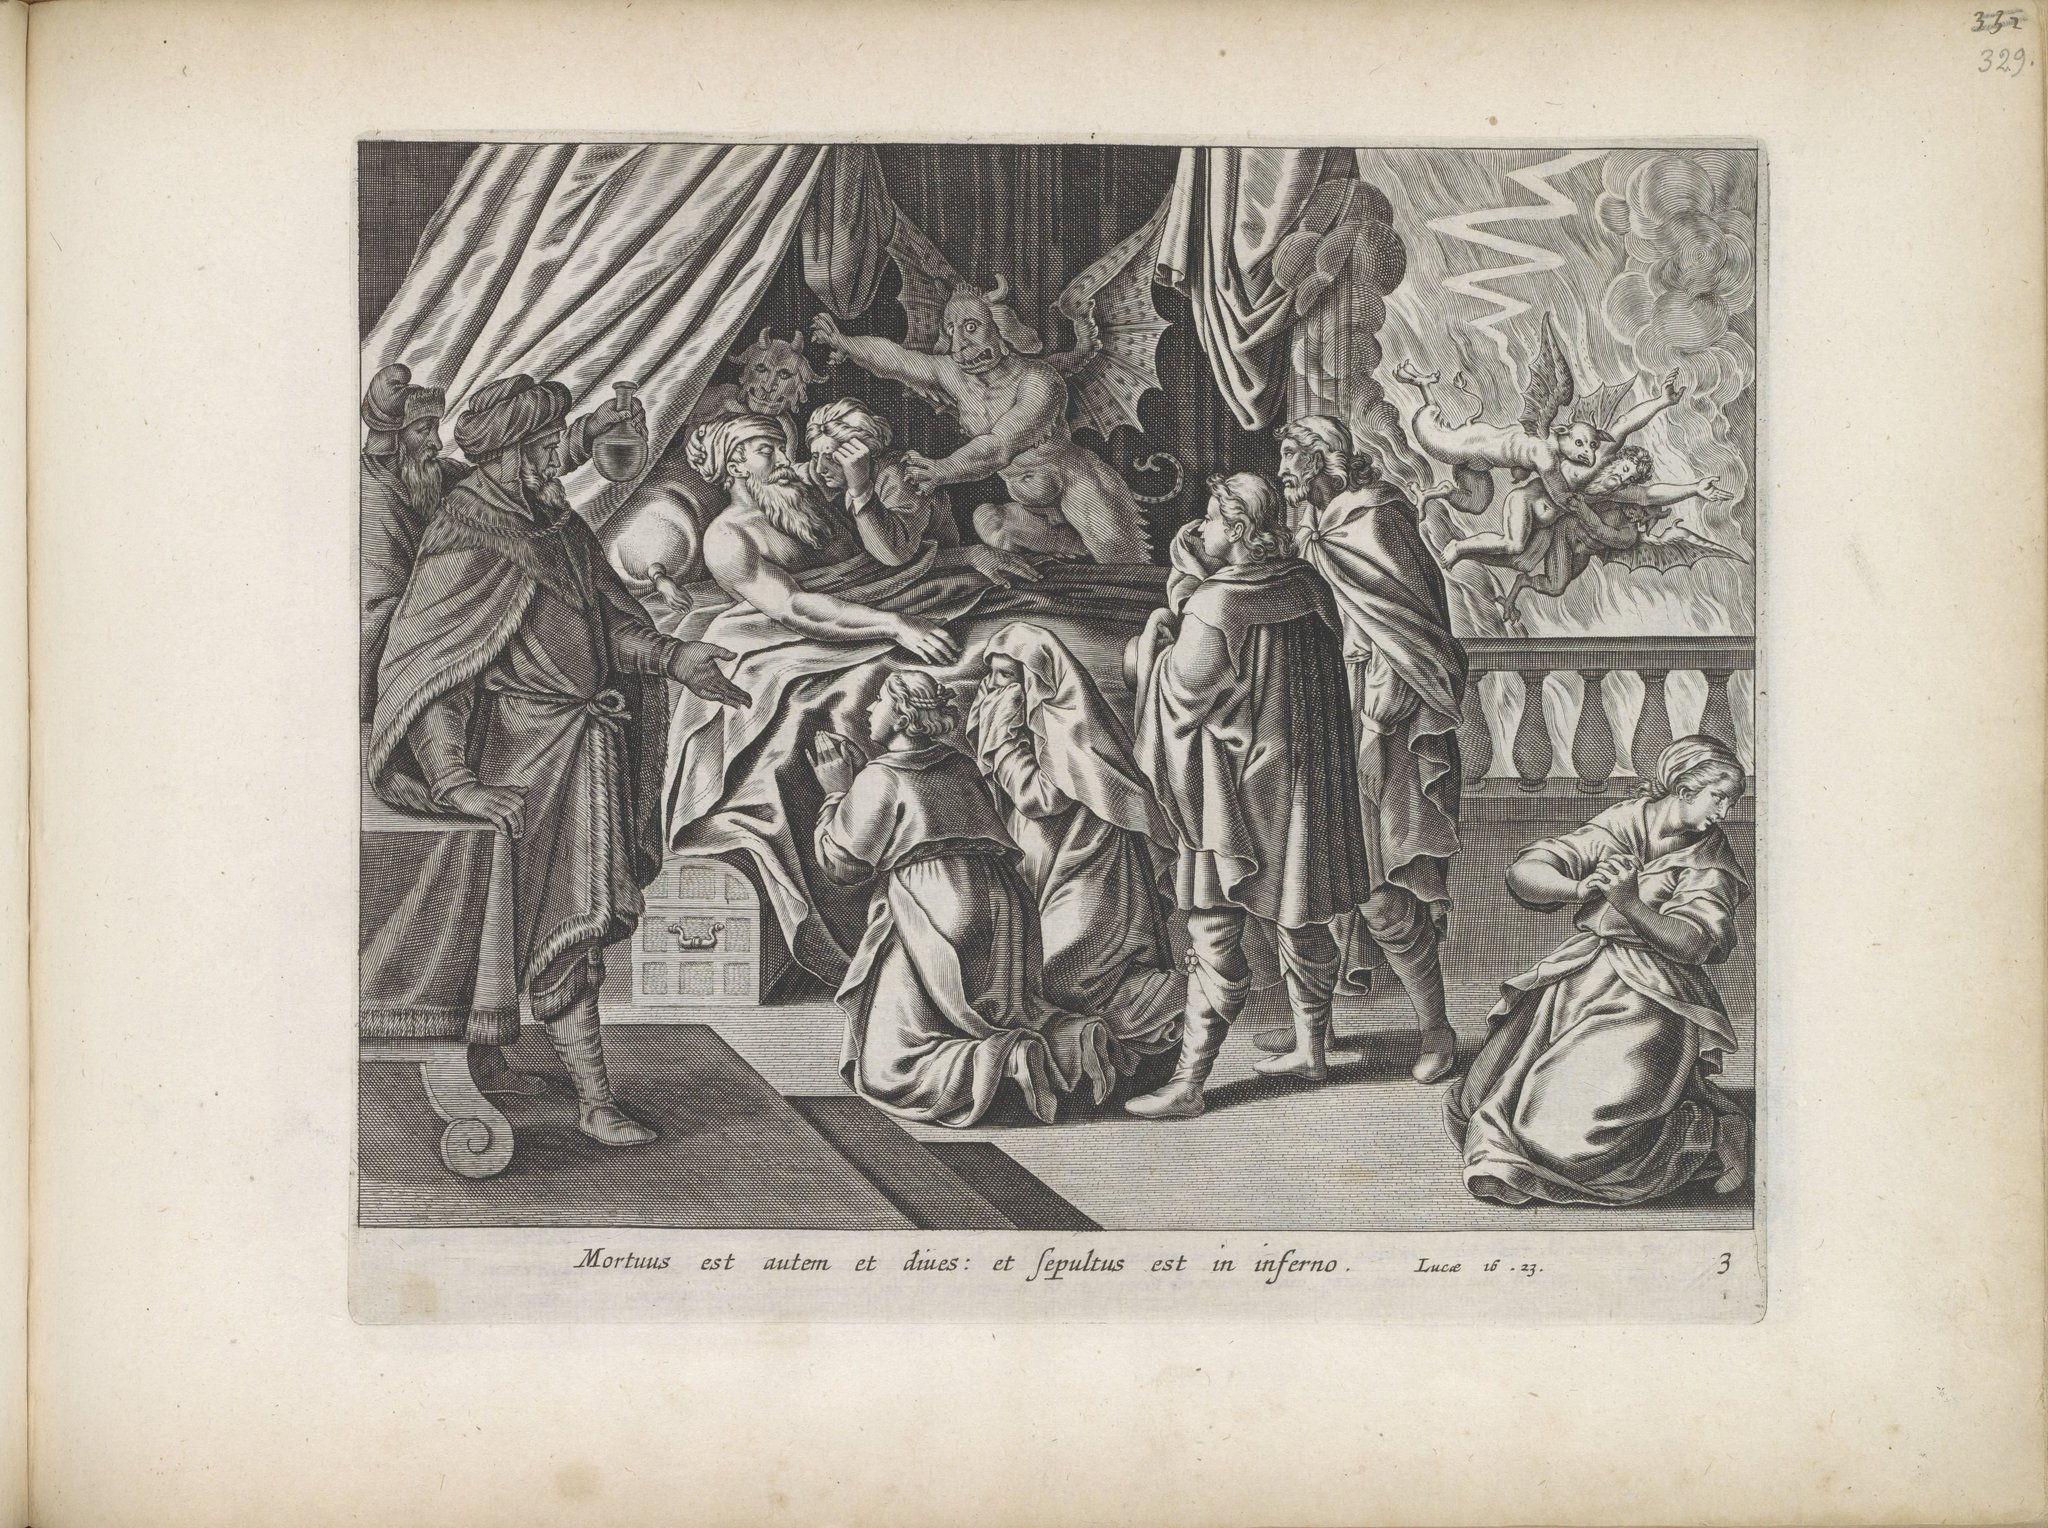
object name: print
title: Theatrum Biblicum Hoc Est Historiae Sacrae Veteris et Novi Testamenti Tabulis Aeneis Expressae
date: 1643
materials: paper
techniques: engraving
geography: amsterdam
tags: dives dies; his soul is brought into hell by devils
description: De rijke man ligt in een bed, omgeven door doktoren, priesters en wenende vrouwen. Twee duivels staan naast zijn bed. Op de achtergrond vliegen twee duivels met de ziel van de rijke man richting de krochten van de hel. Onder de voorstelling een verwijzing in het Latijn naar de Bijbeltekst in Luc. 16:23. Deze prent maakt deel uit van een album.